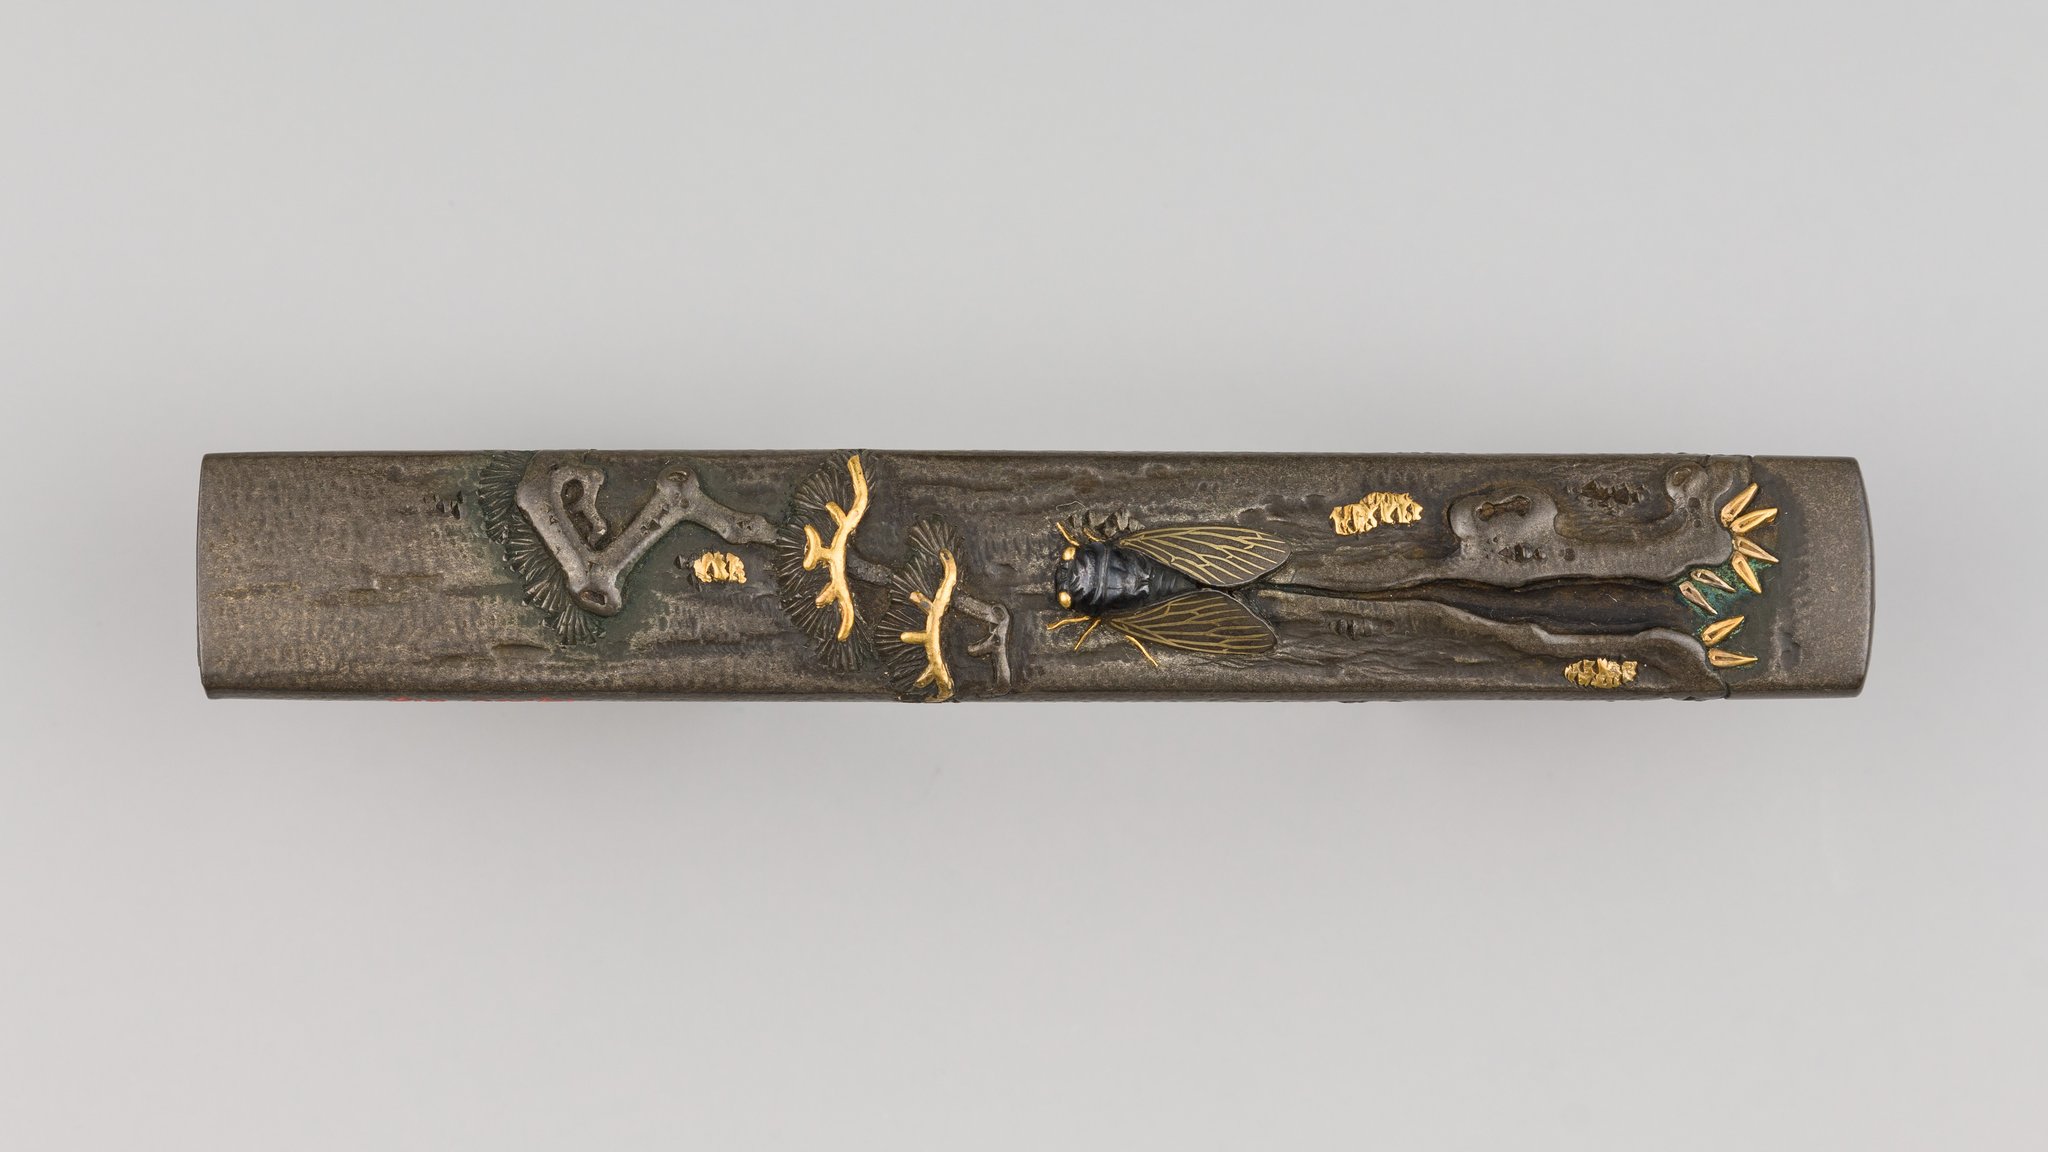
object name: knife handle kozuka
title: Knife Handle (Kozuka)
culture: japanese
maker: iwama masayoshi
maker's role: maker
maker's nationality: japanese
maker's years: 1764-1837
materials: gold alloy, silver alloy, gold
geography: japan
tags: insects